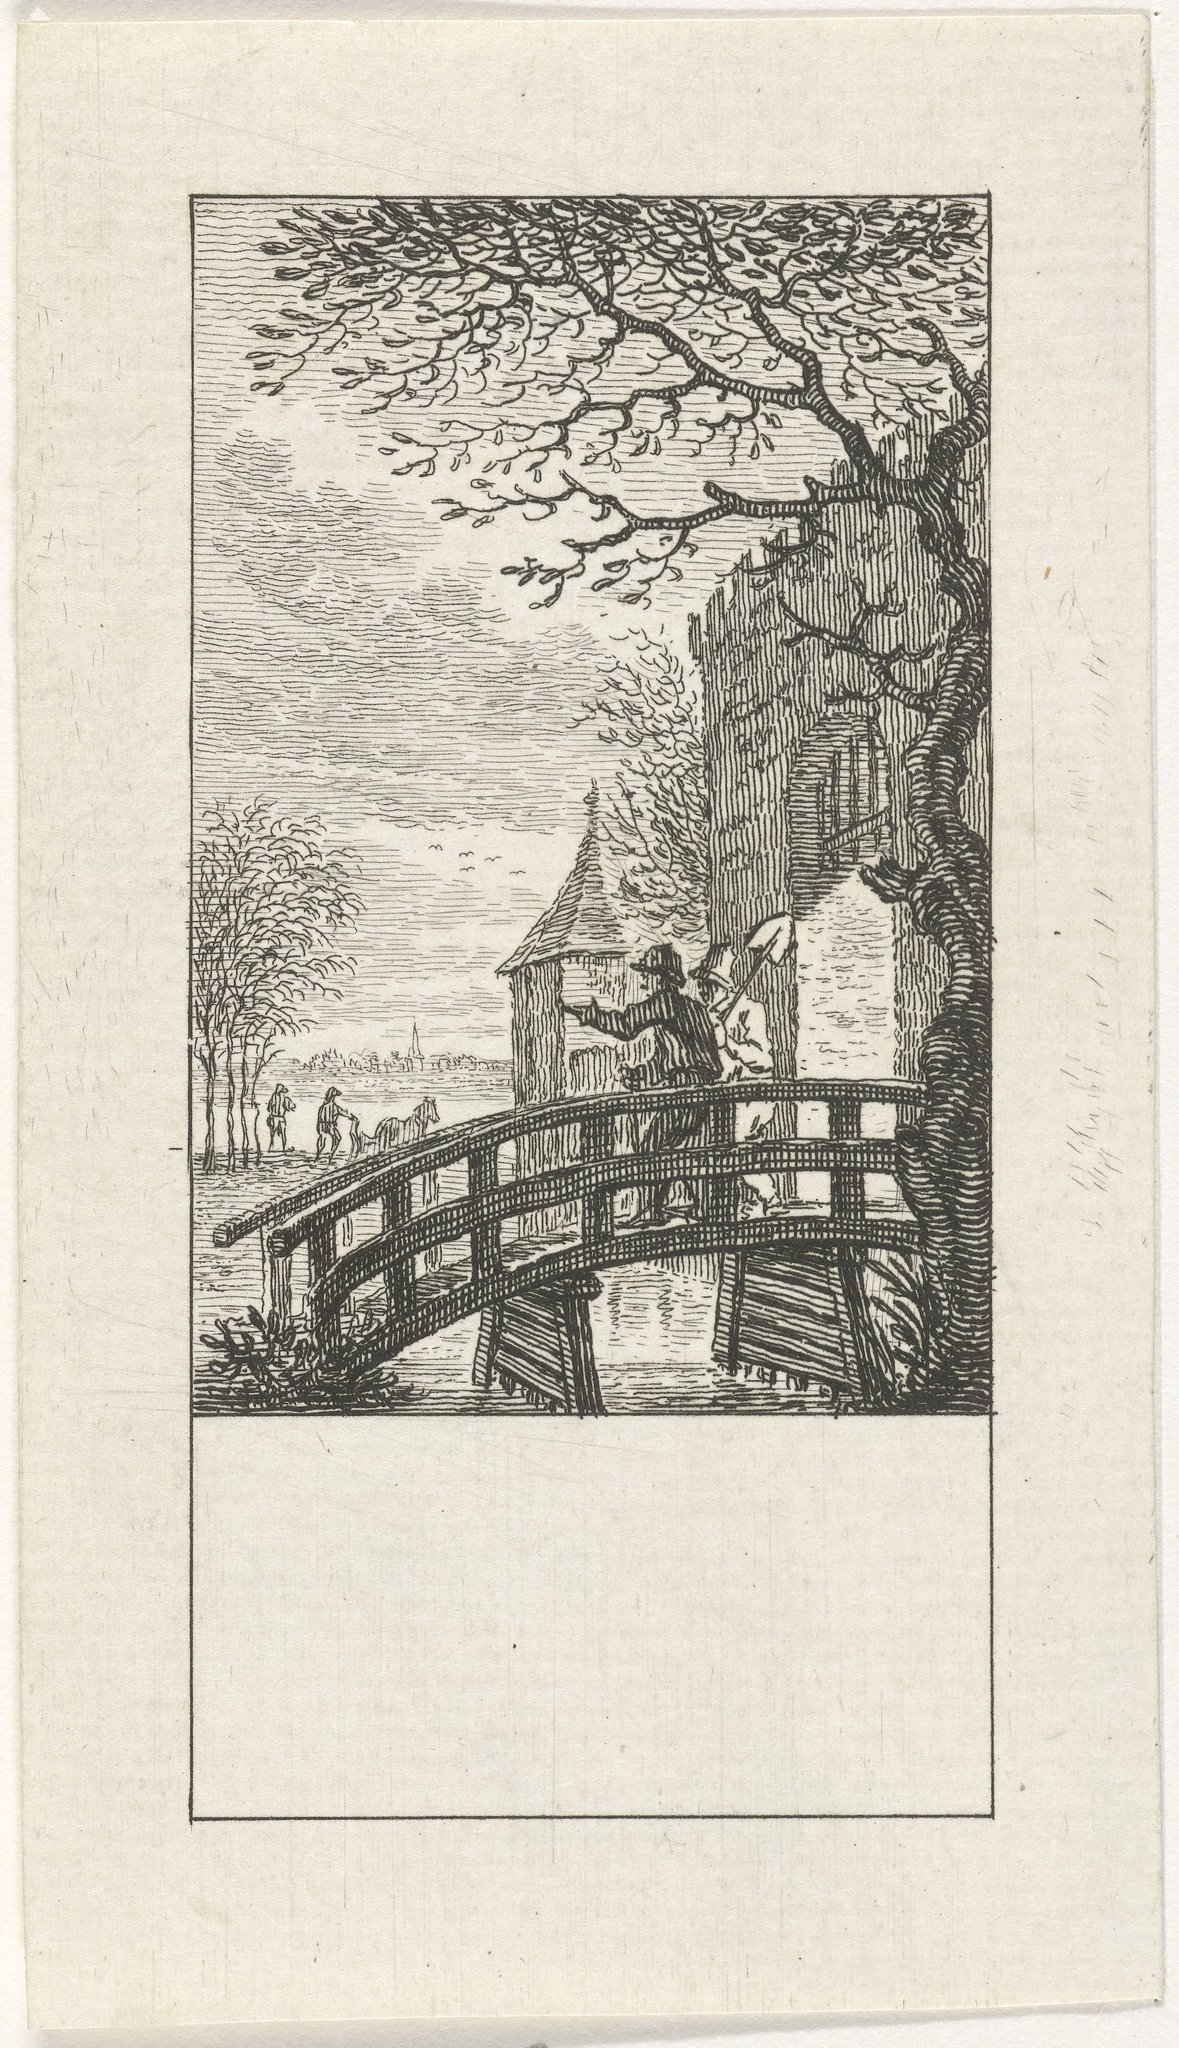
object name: print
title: De twaalf maanden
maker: simon fokke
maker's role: draughtsman, print maker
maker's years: 1712-1784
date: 1722-1784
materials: paper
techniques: etching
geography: amsterdam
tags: april ~ other concepts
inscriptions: collector's mark: Lugt 240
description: Uit een serie van twaalf prenten, de verbeelding van de maand april. Figuren verlaten de stad via een stadspoort om op het land te gaan werken.